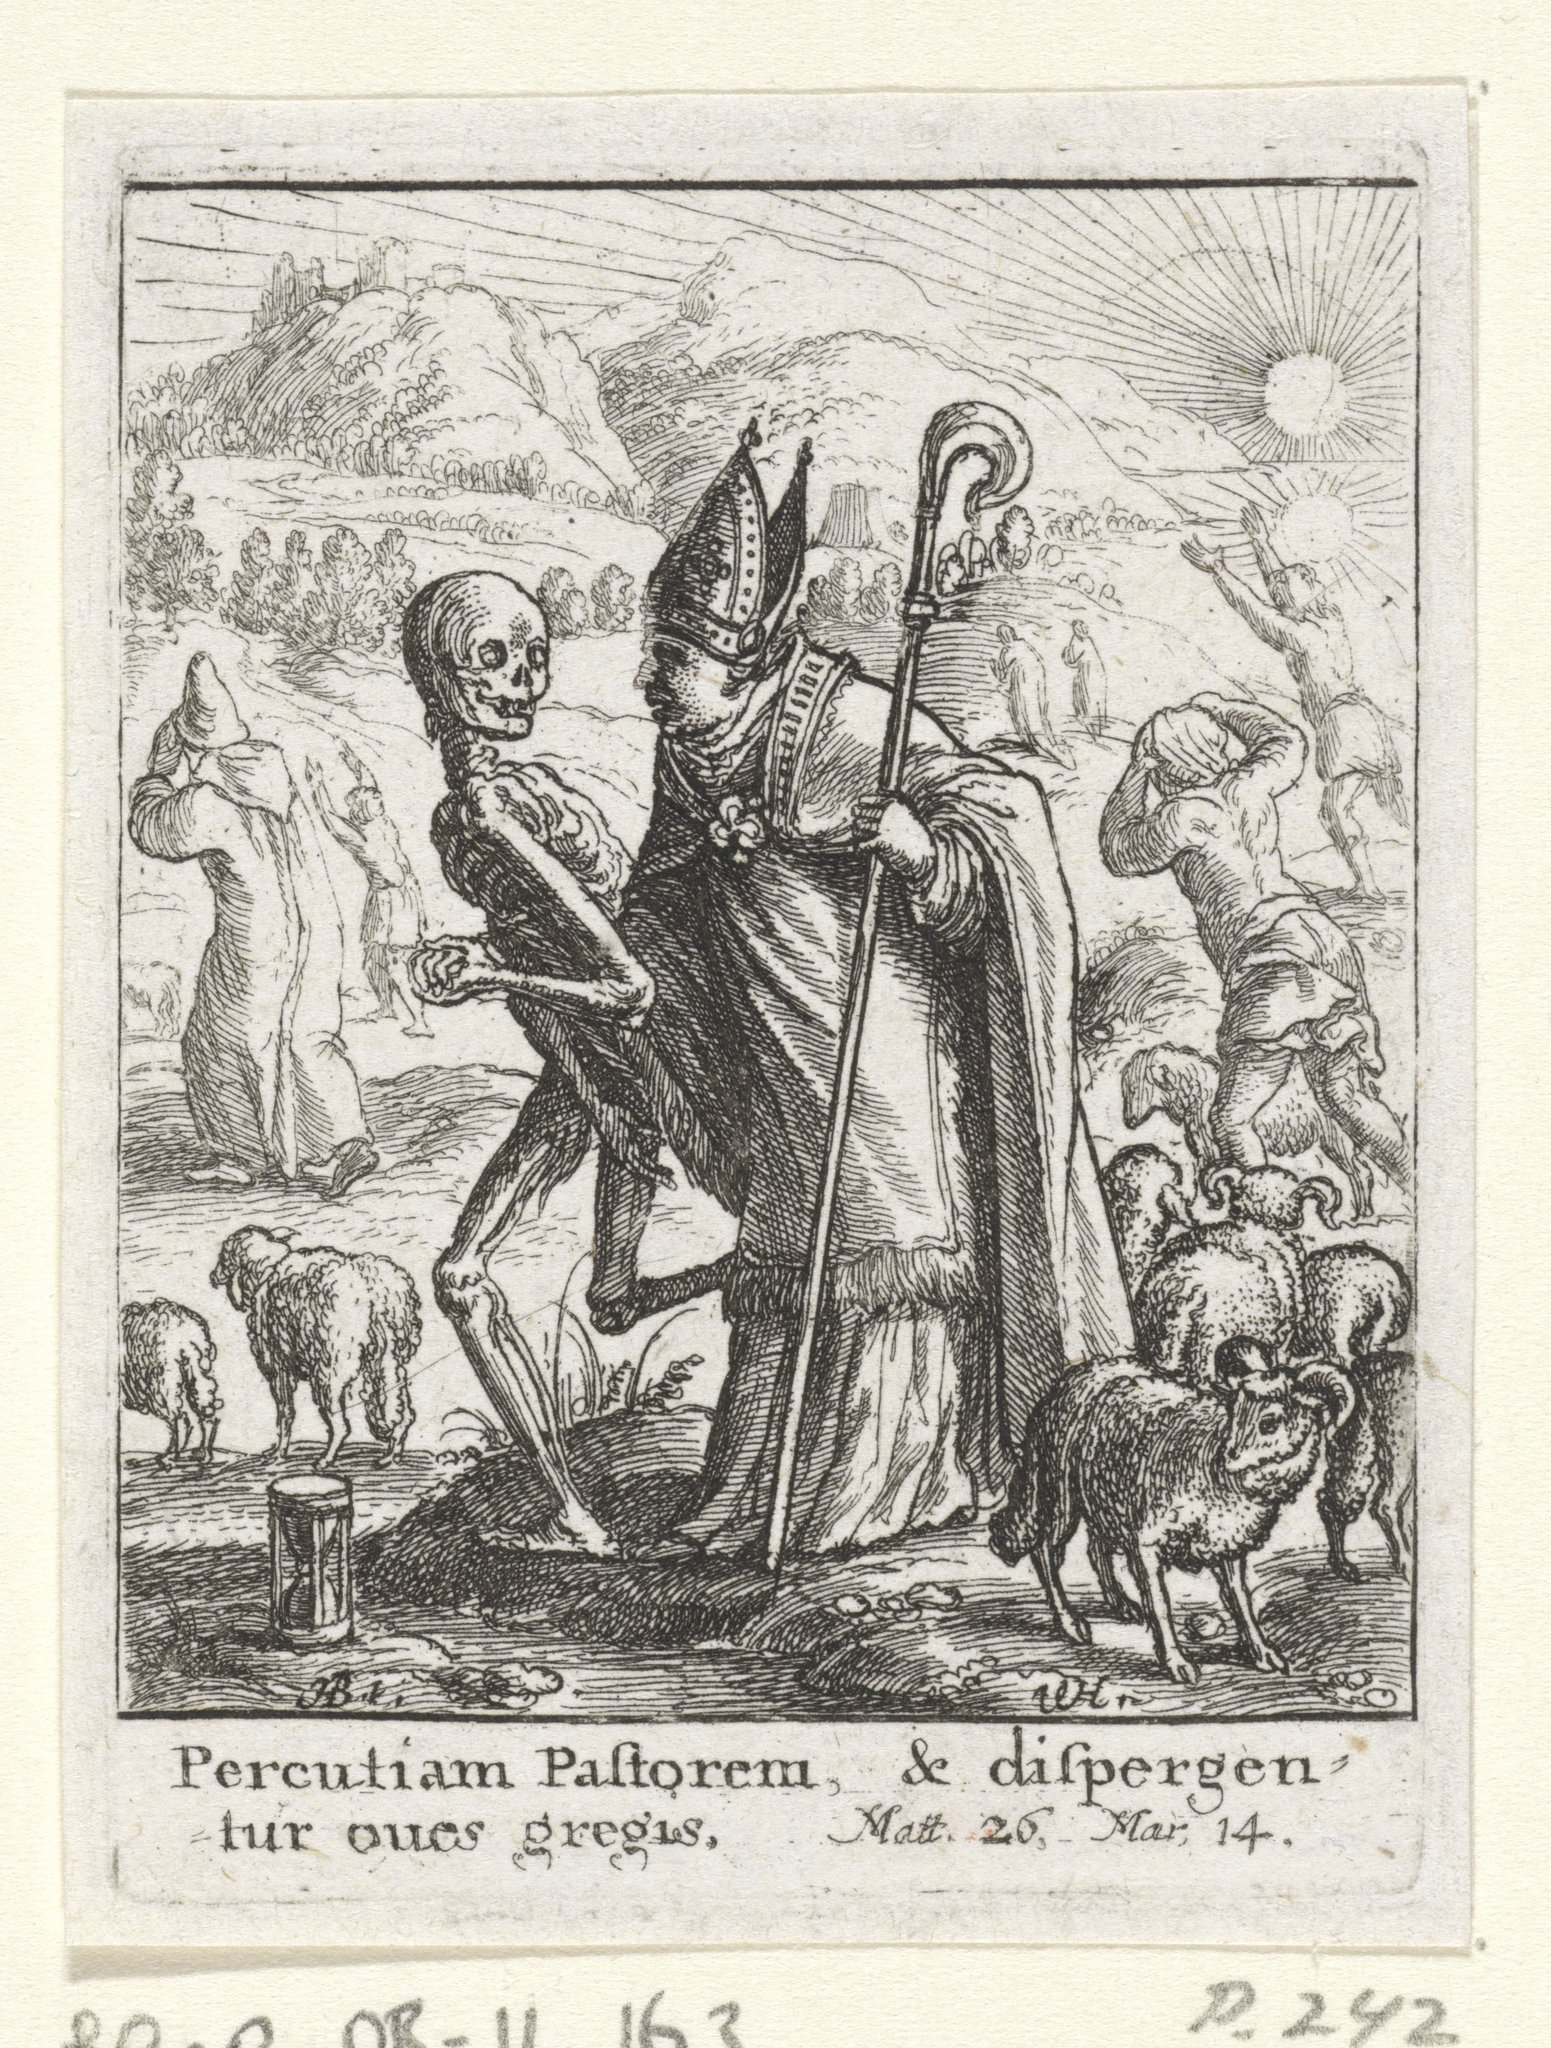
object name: book illustration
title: Dodendans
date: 1680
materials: paper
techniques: etching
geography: antwerp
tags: archbishop, bishop, etc. (roman catholic), dance of death; death together with one or more human beings, hourglass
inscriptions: collector's mark: Lugt 240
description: Een bisschop loopt gearmd met de Dood door een landschap met schapen. Voor hun op de grond staat een zandloper.